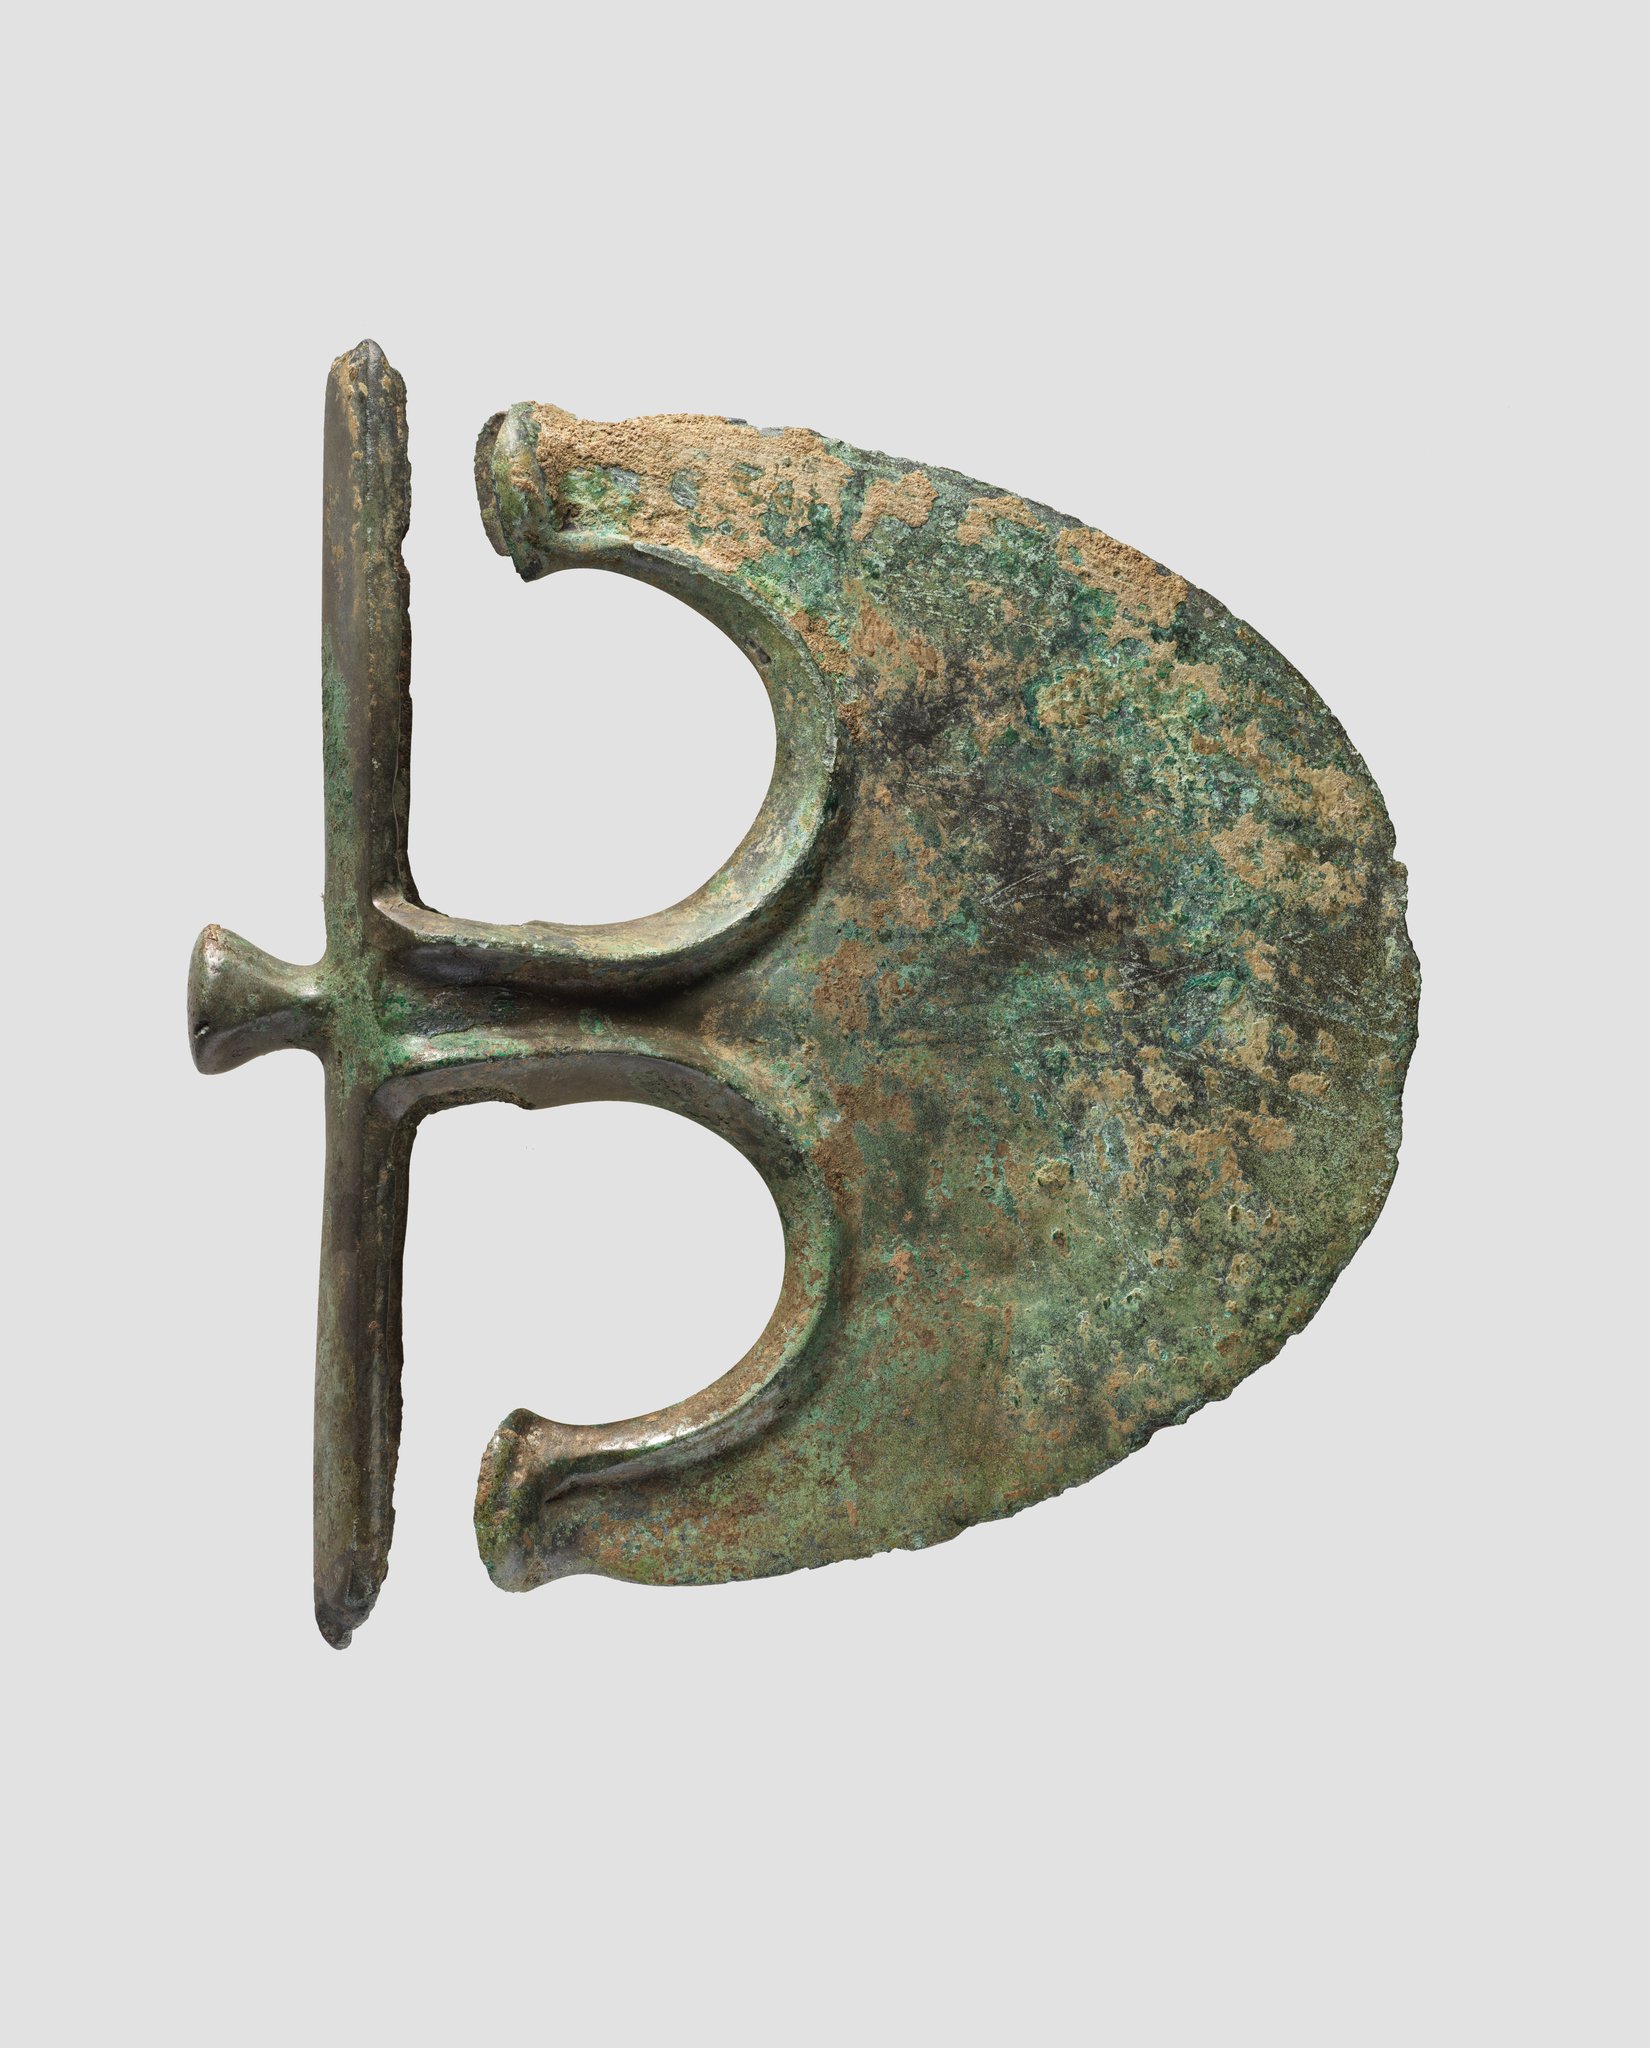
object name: axe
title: Axe head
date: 2333-2001 BCE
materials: bronze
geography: western asia